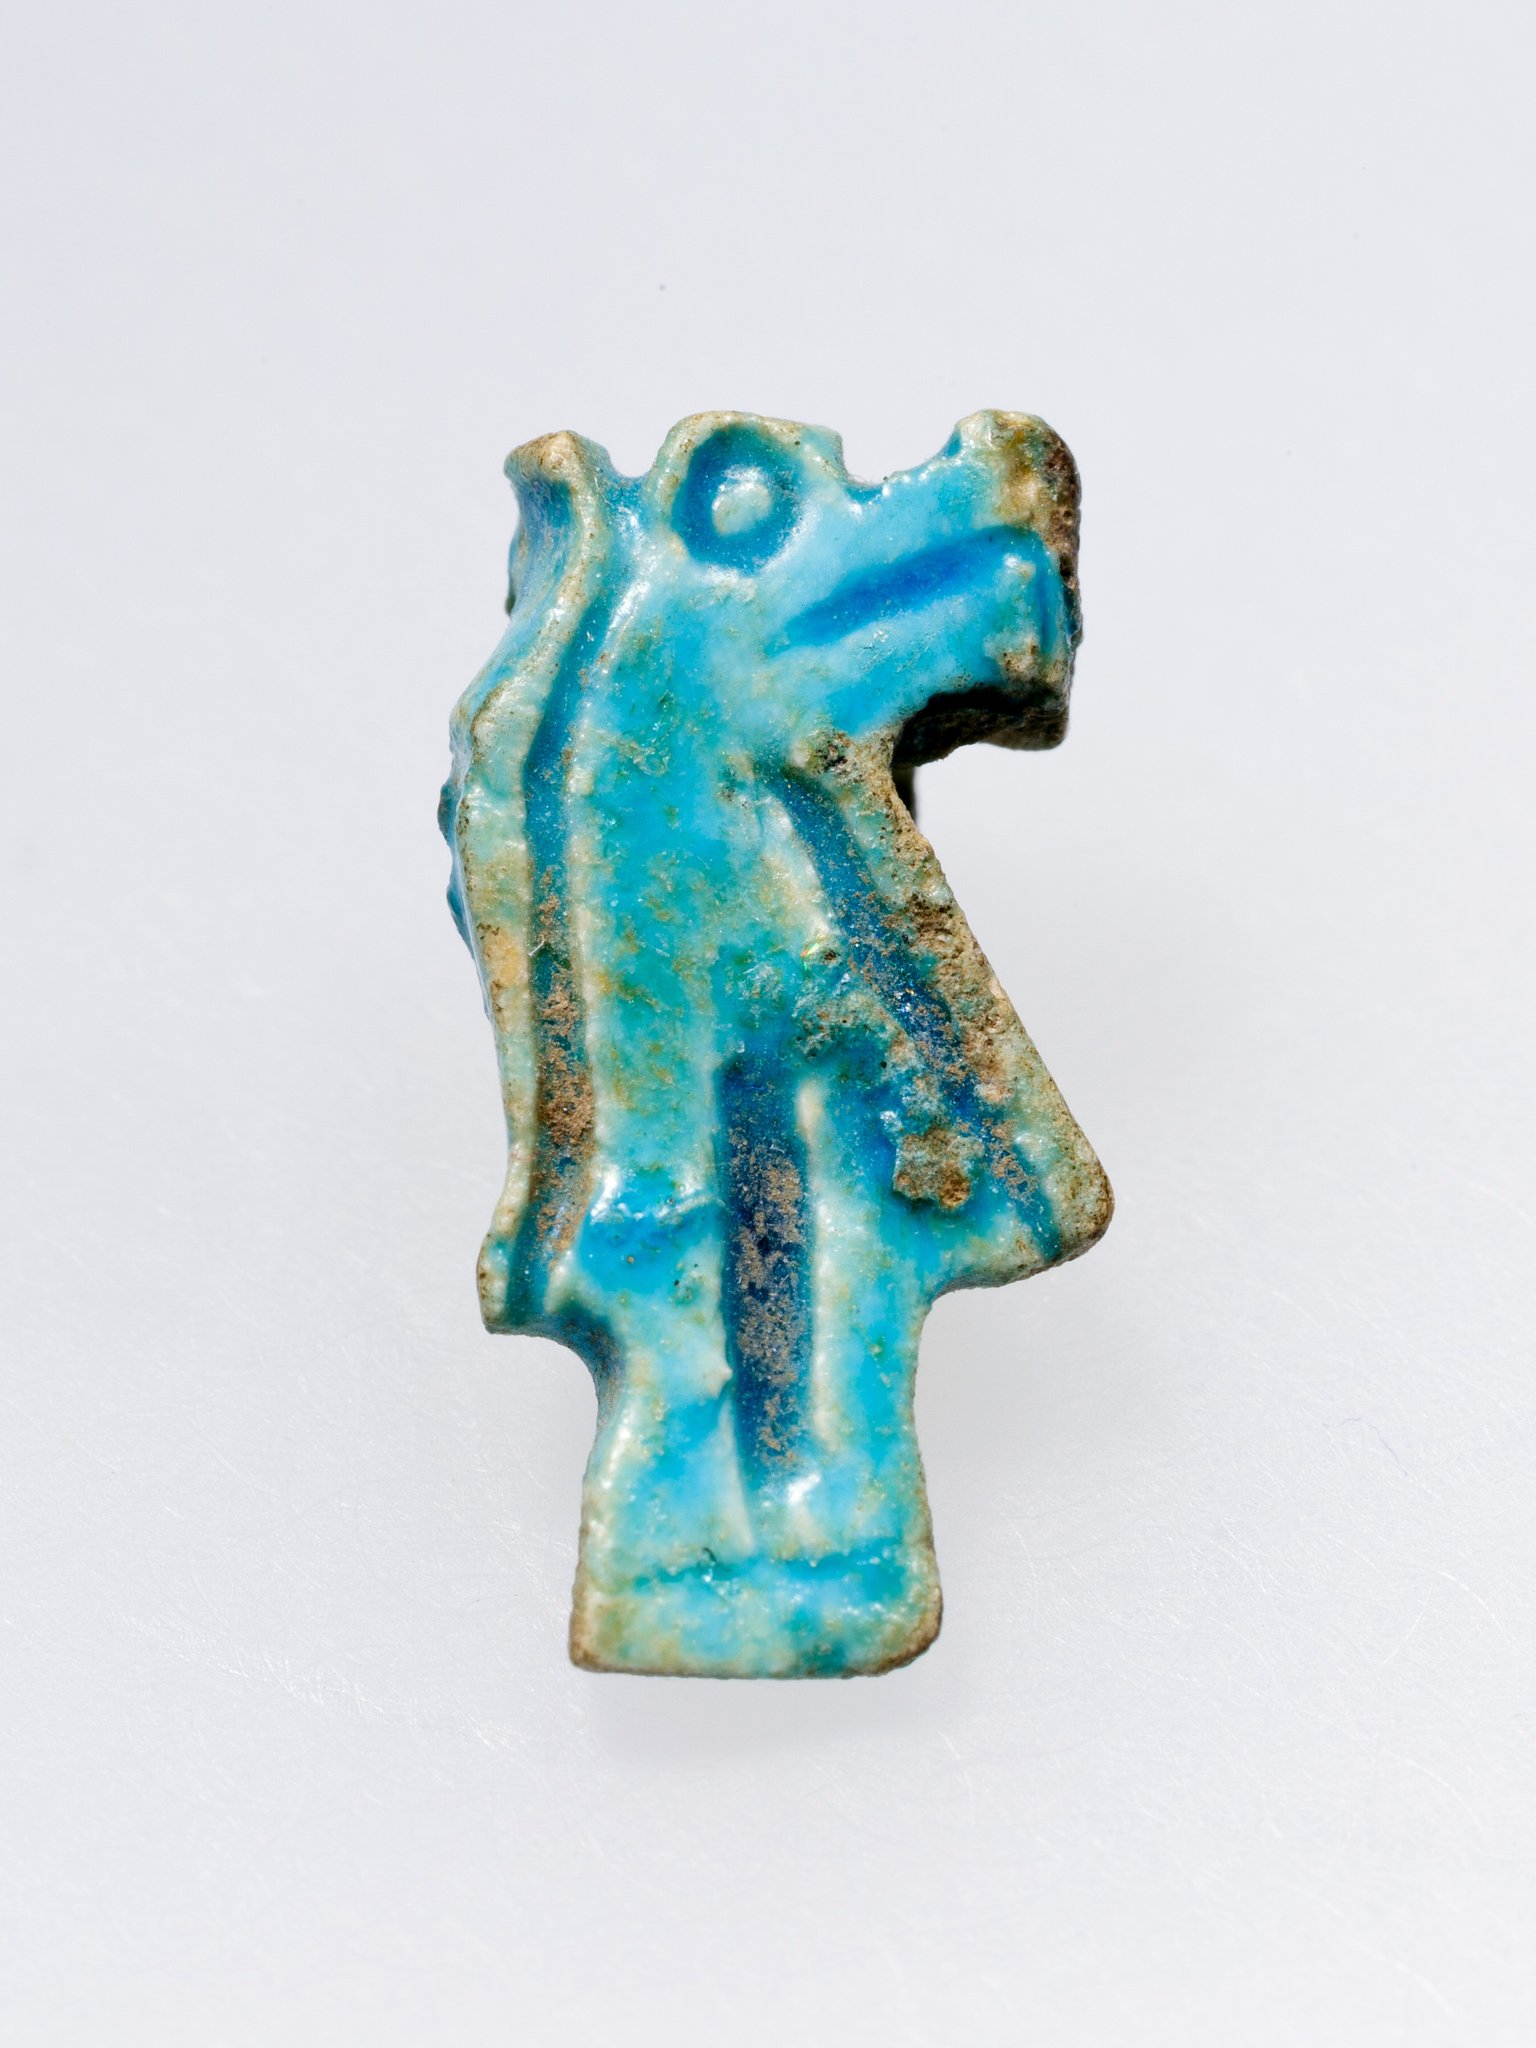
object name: amulet, taweret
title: Taweret Amulet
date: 1295-1070 BCE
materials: stone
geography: egypt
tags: taweret